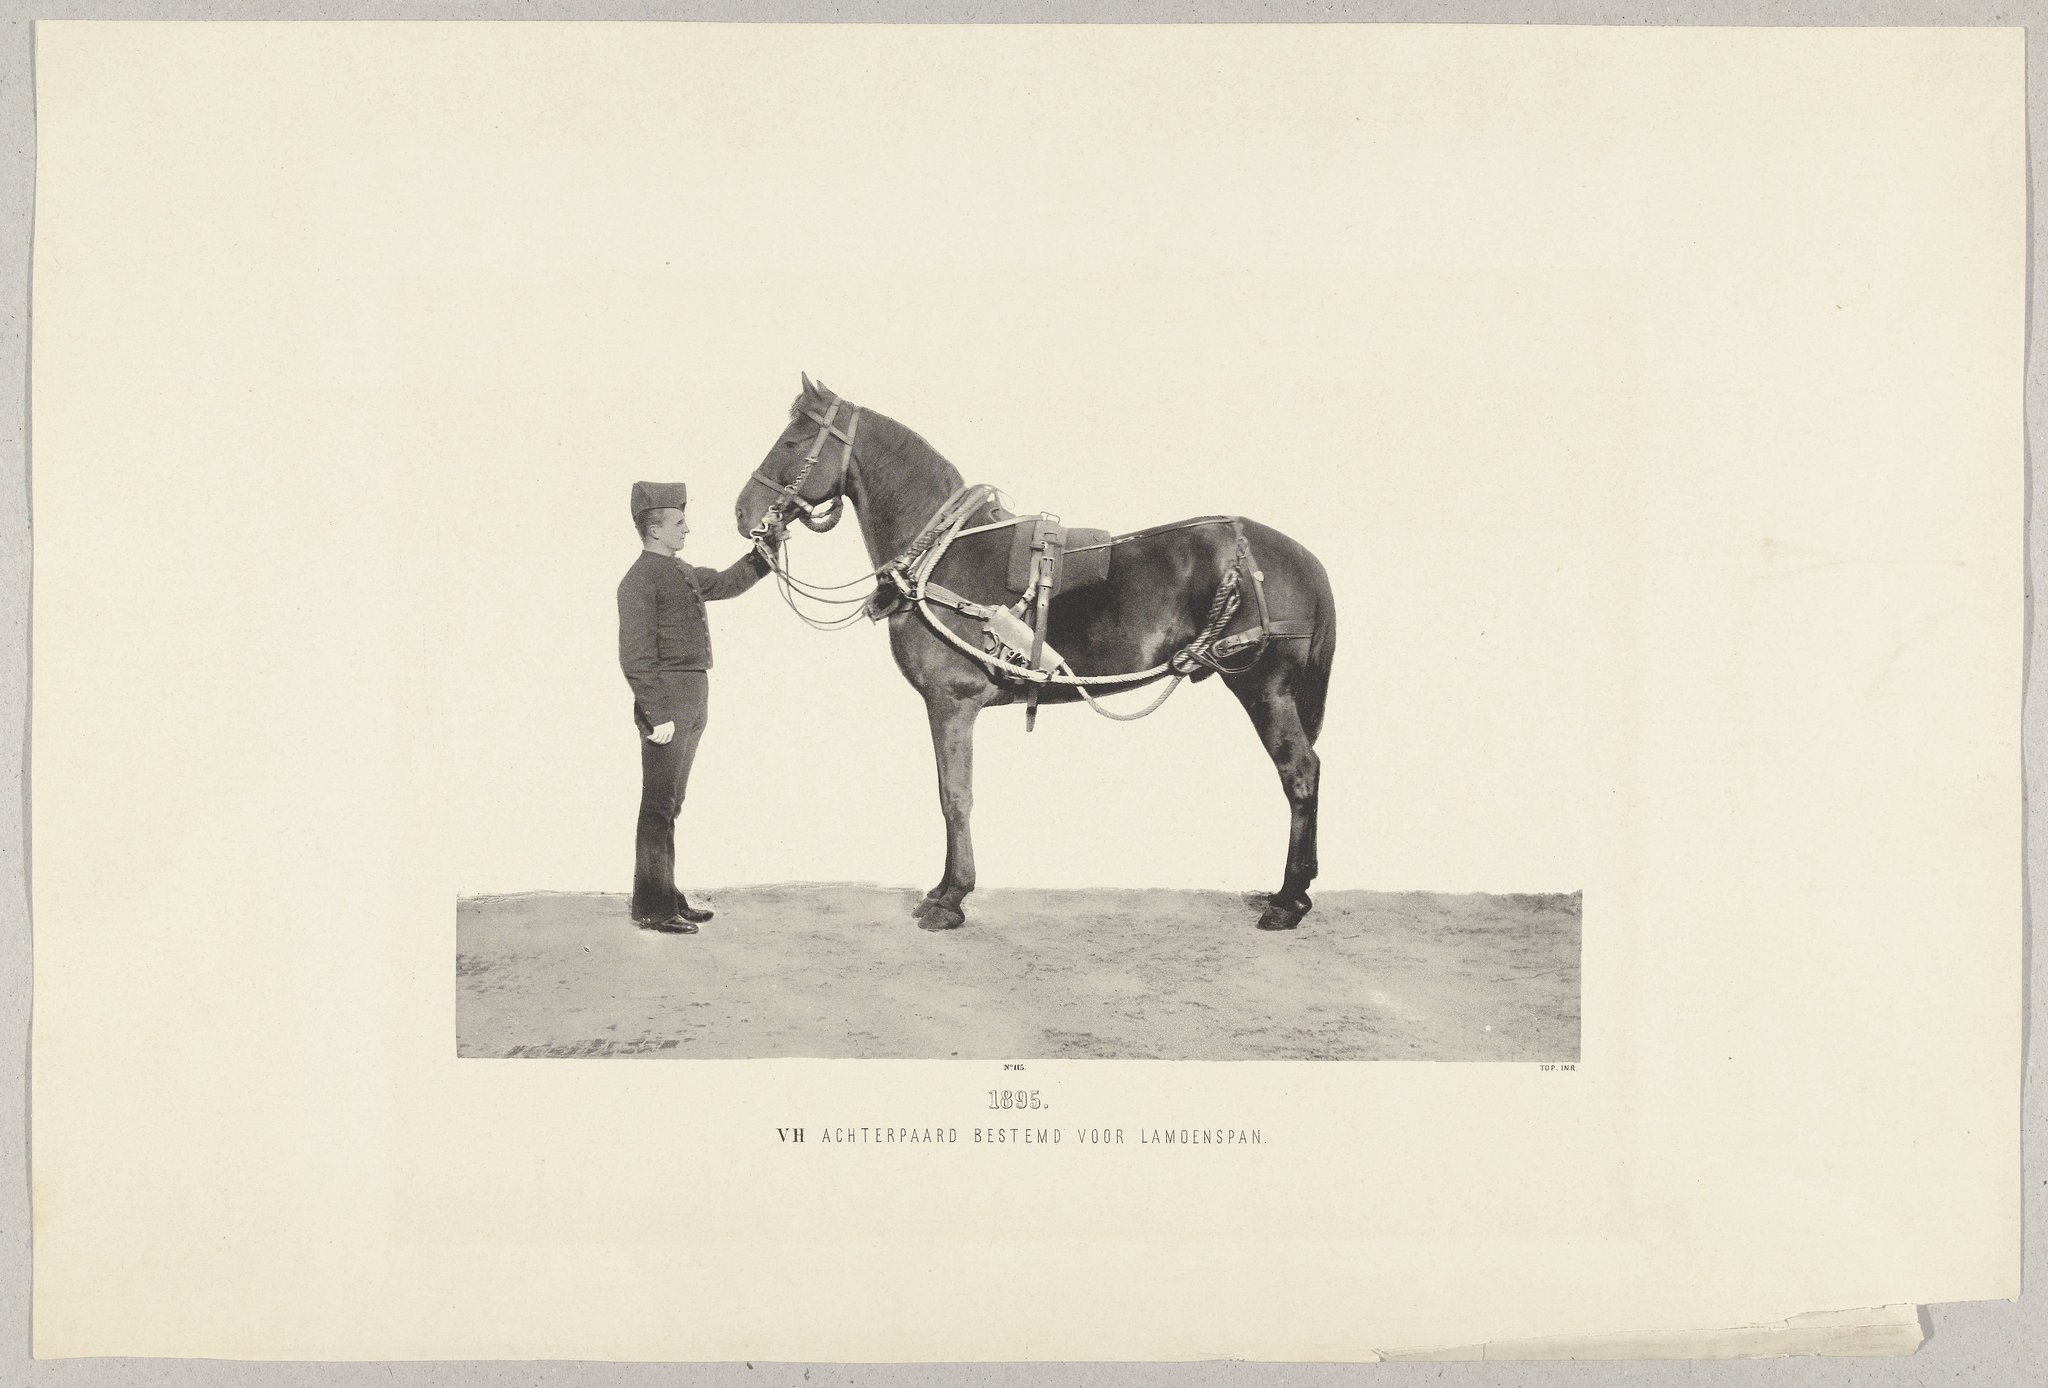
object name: photomechanical print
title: Opgetuigd legerpaard, en profil gezien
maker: Anonymous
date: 1895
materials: paper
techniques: photolithography, rotogravure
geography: netherlands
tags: saddle and bridle (saddlery), horse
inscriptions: inscription: ‘No 115/ TOP.INR./ 1895./ VH ACHTERPAARD BESTEMD VOOR LAMOENSPAN.’